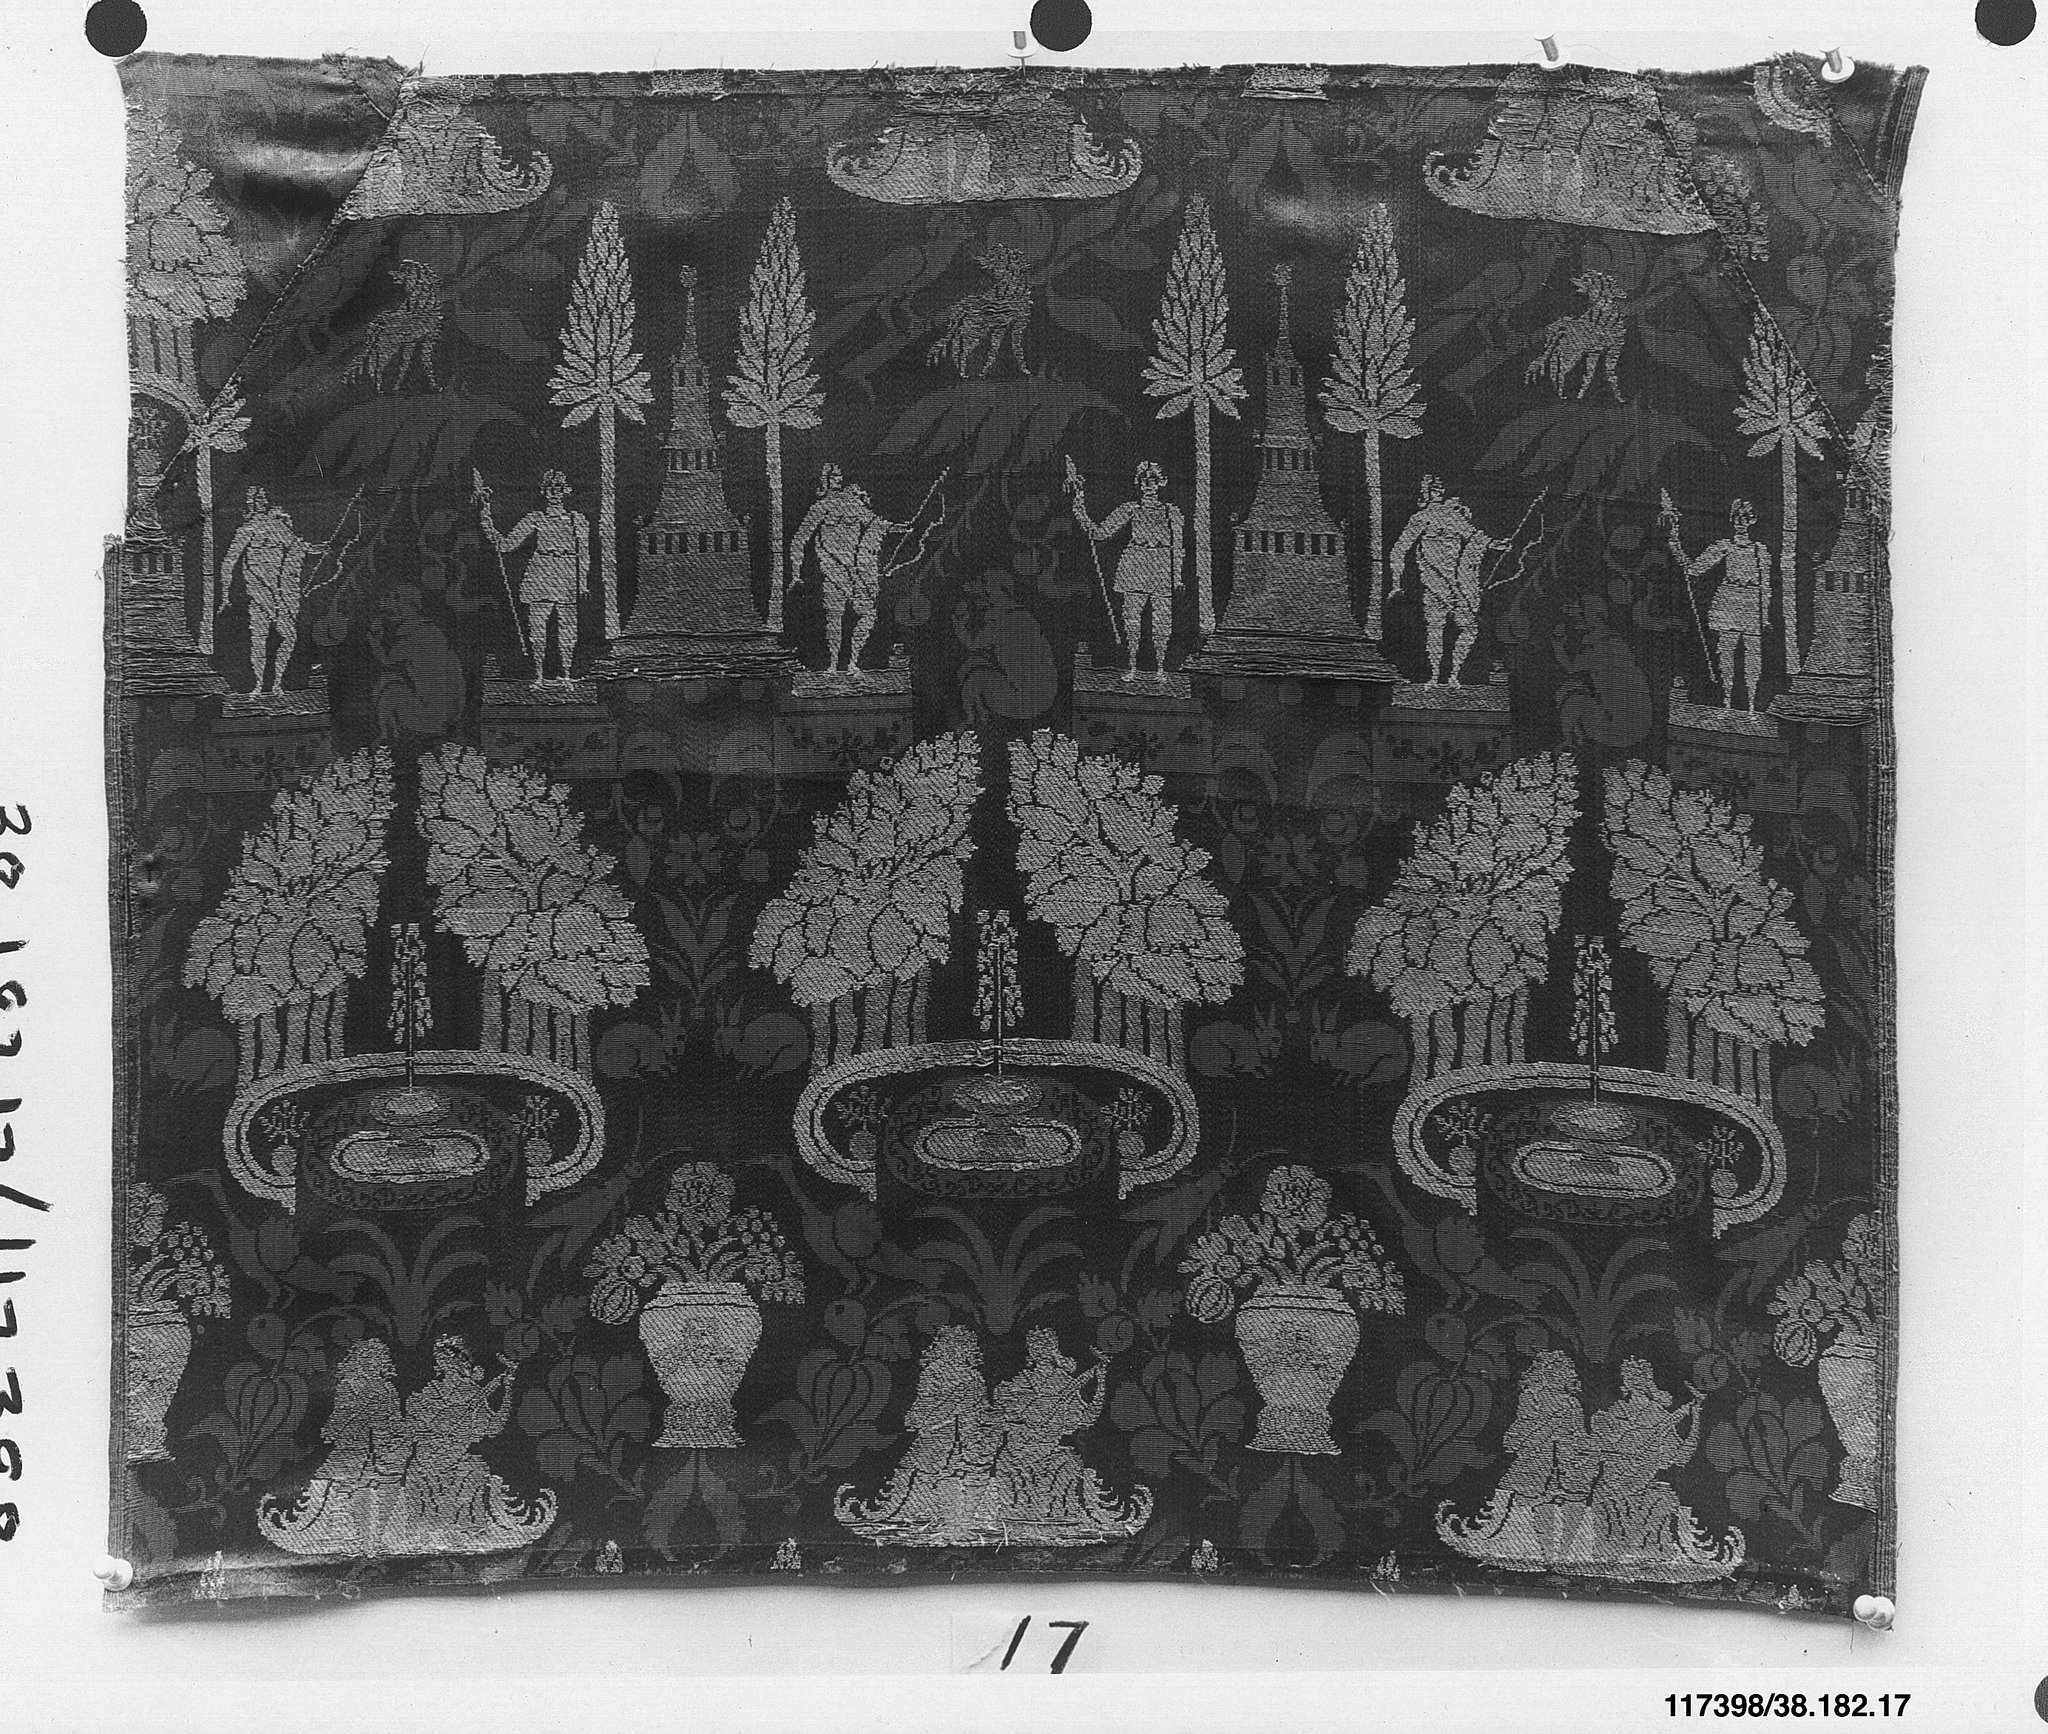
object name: piece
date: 1701-1733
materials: metal thread, silk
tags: birds,bow and arrow,men,rabbits,trees